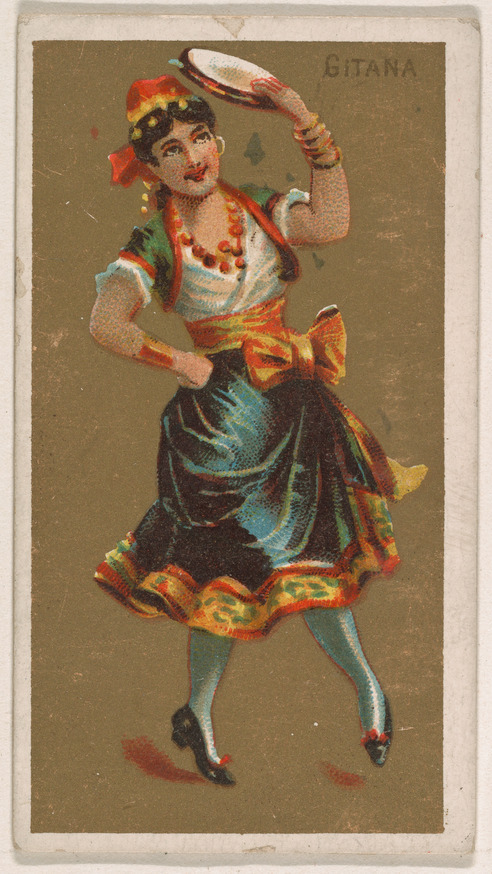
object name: print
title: Gitana, from National Dances (N225, Type 1) issued by Kinney Bros.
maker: kinney brothers tobacco company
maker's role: publisher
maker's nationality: american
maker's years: 1869-2011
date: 1889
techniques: color lithograph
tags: women,dancing,dancers